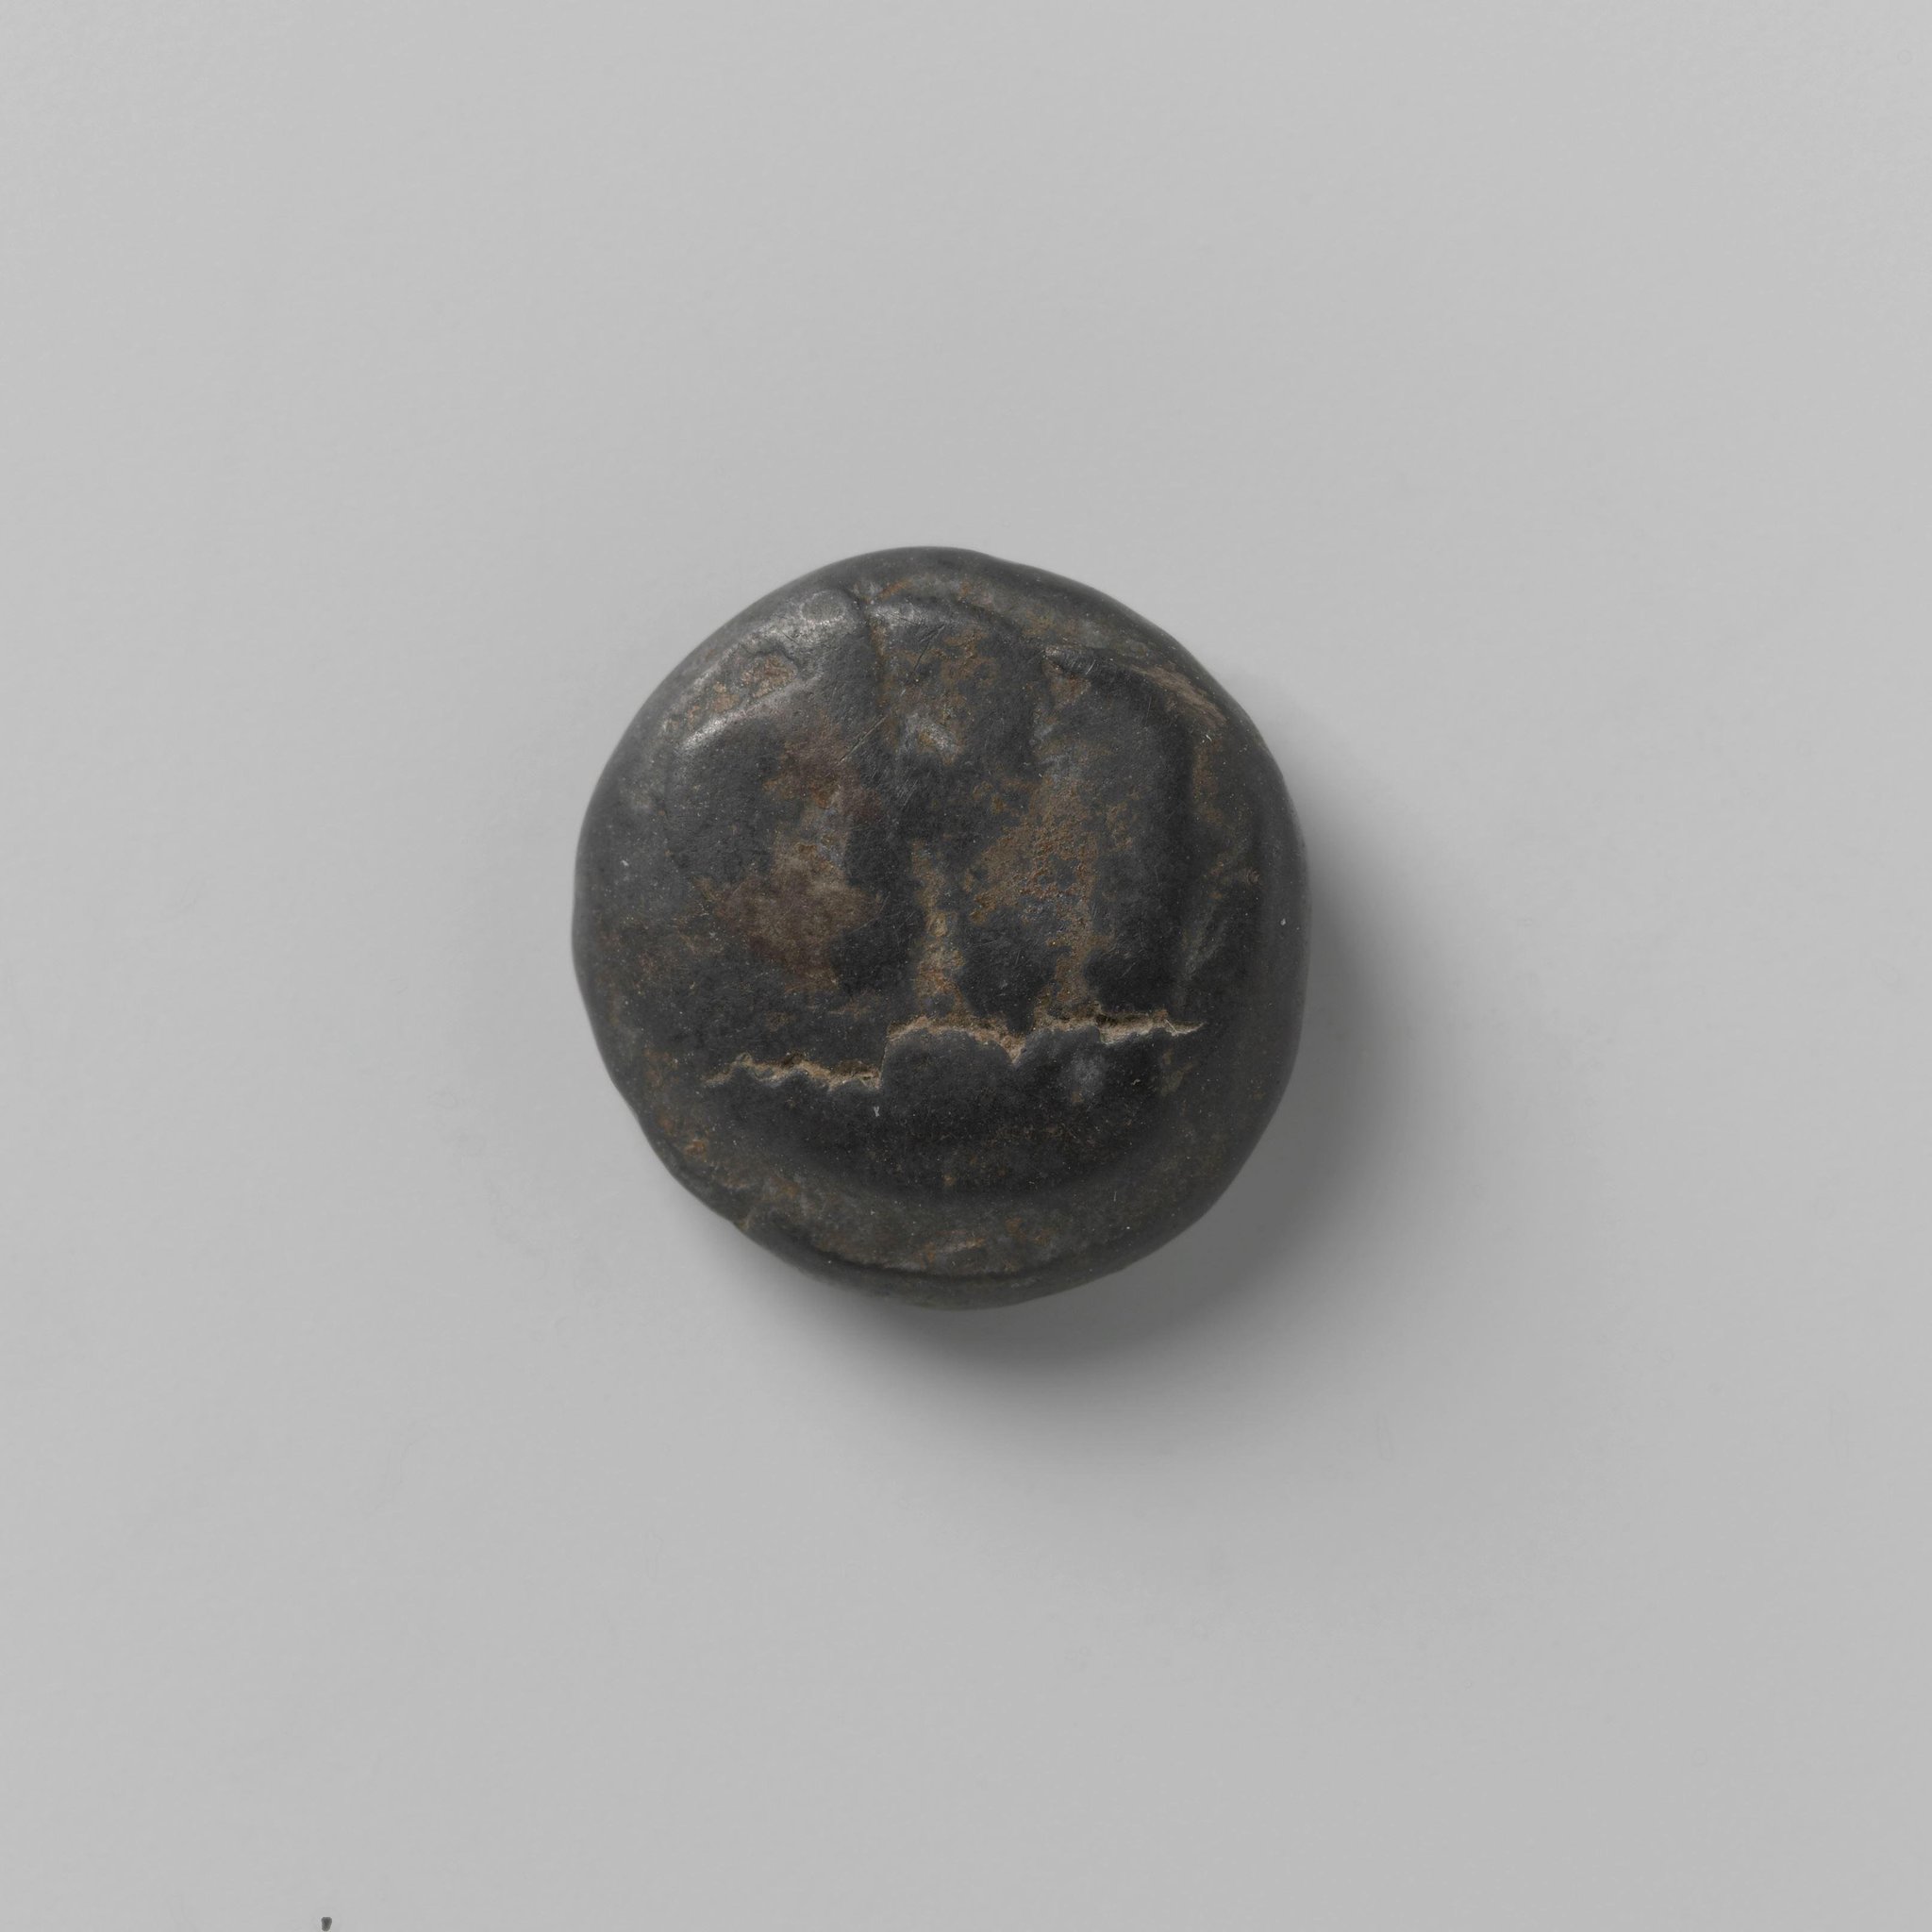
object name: coin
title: Djampel van koninkrijk Majopahit op Java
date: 1290-1520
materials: silver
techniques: striking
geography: java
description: Zilveren schotelvormige munt. Voorzijde: letterteken in devanagari-schrift [maa?]. Keerzijde, figuratie [bloem?].